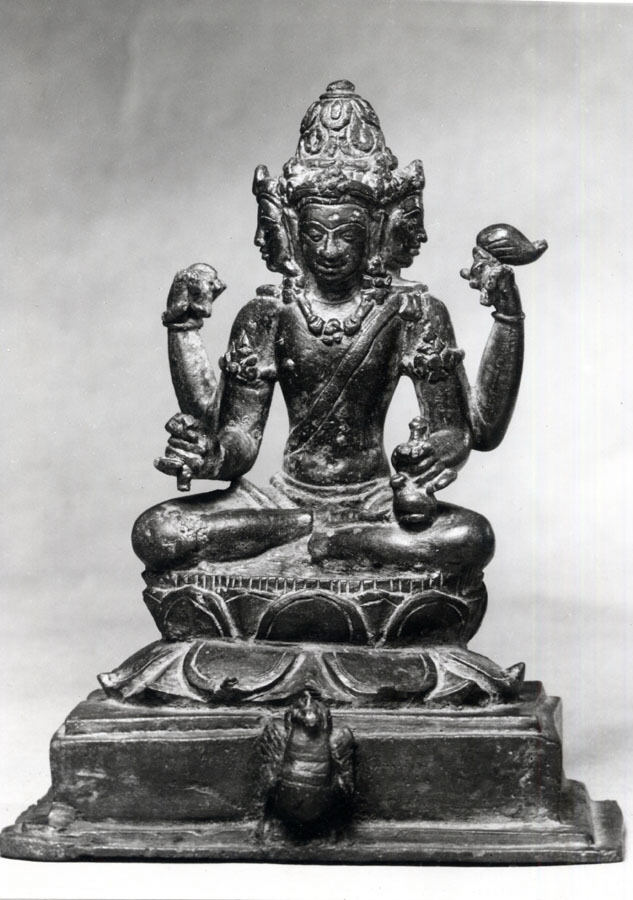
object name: figure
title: Seated Brahma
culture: indonesian, javanese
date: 867-900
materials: bronze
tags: lotuses,brahma